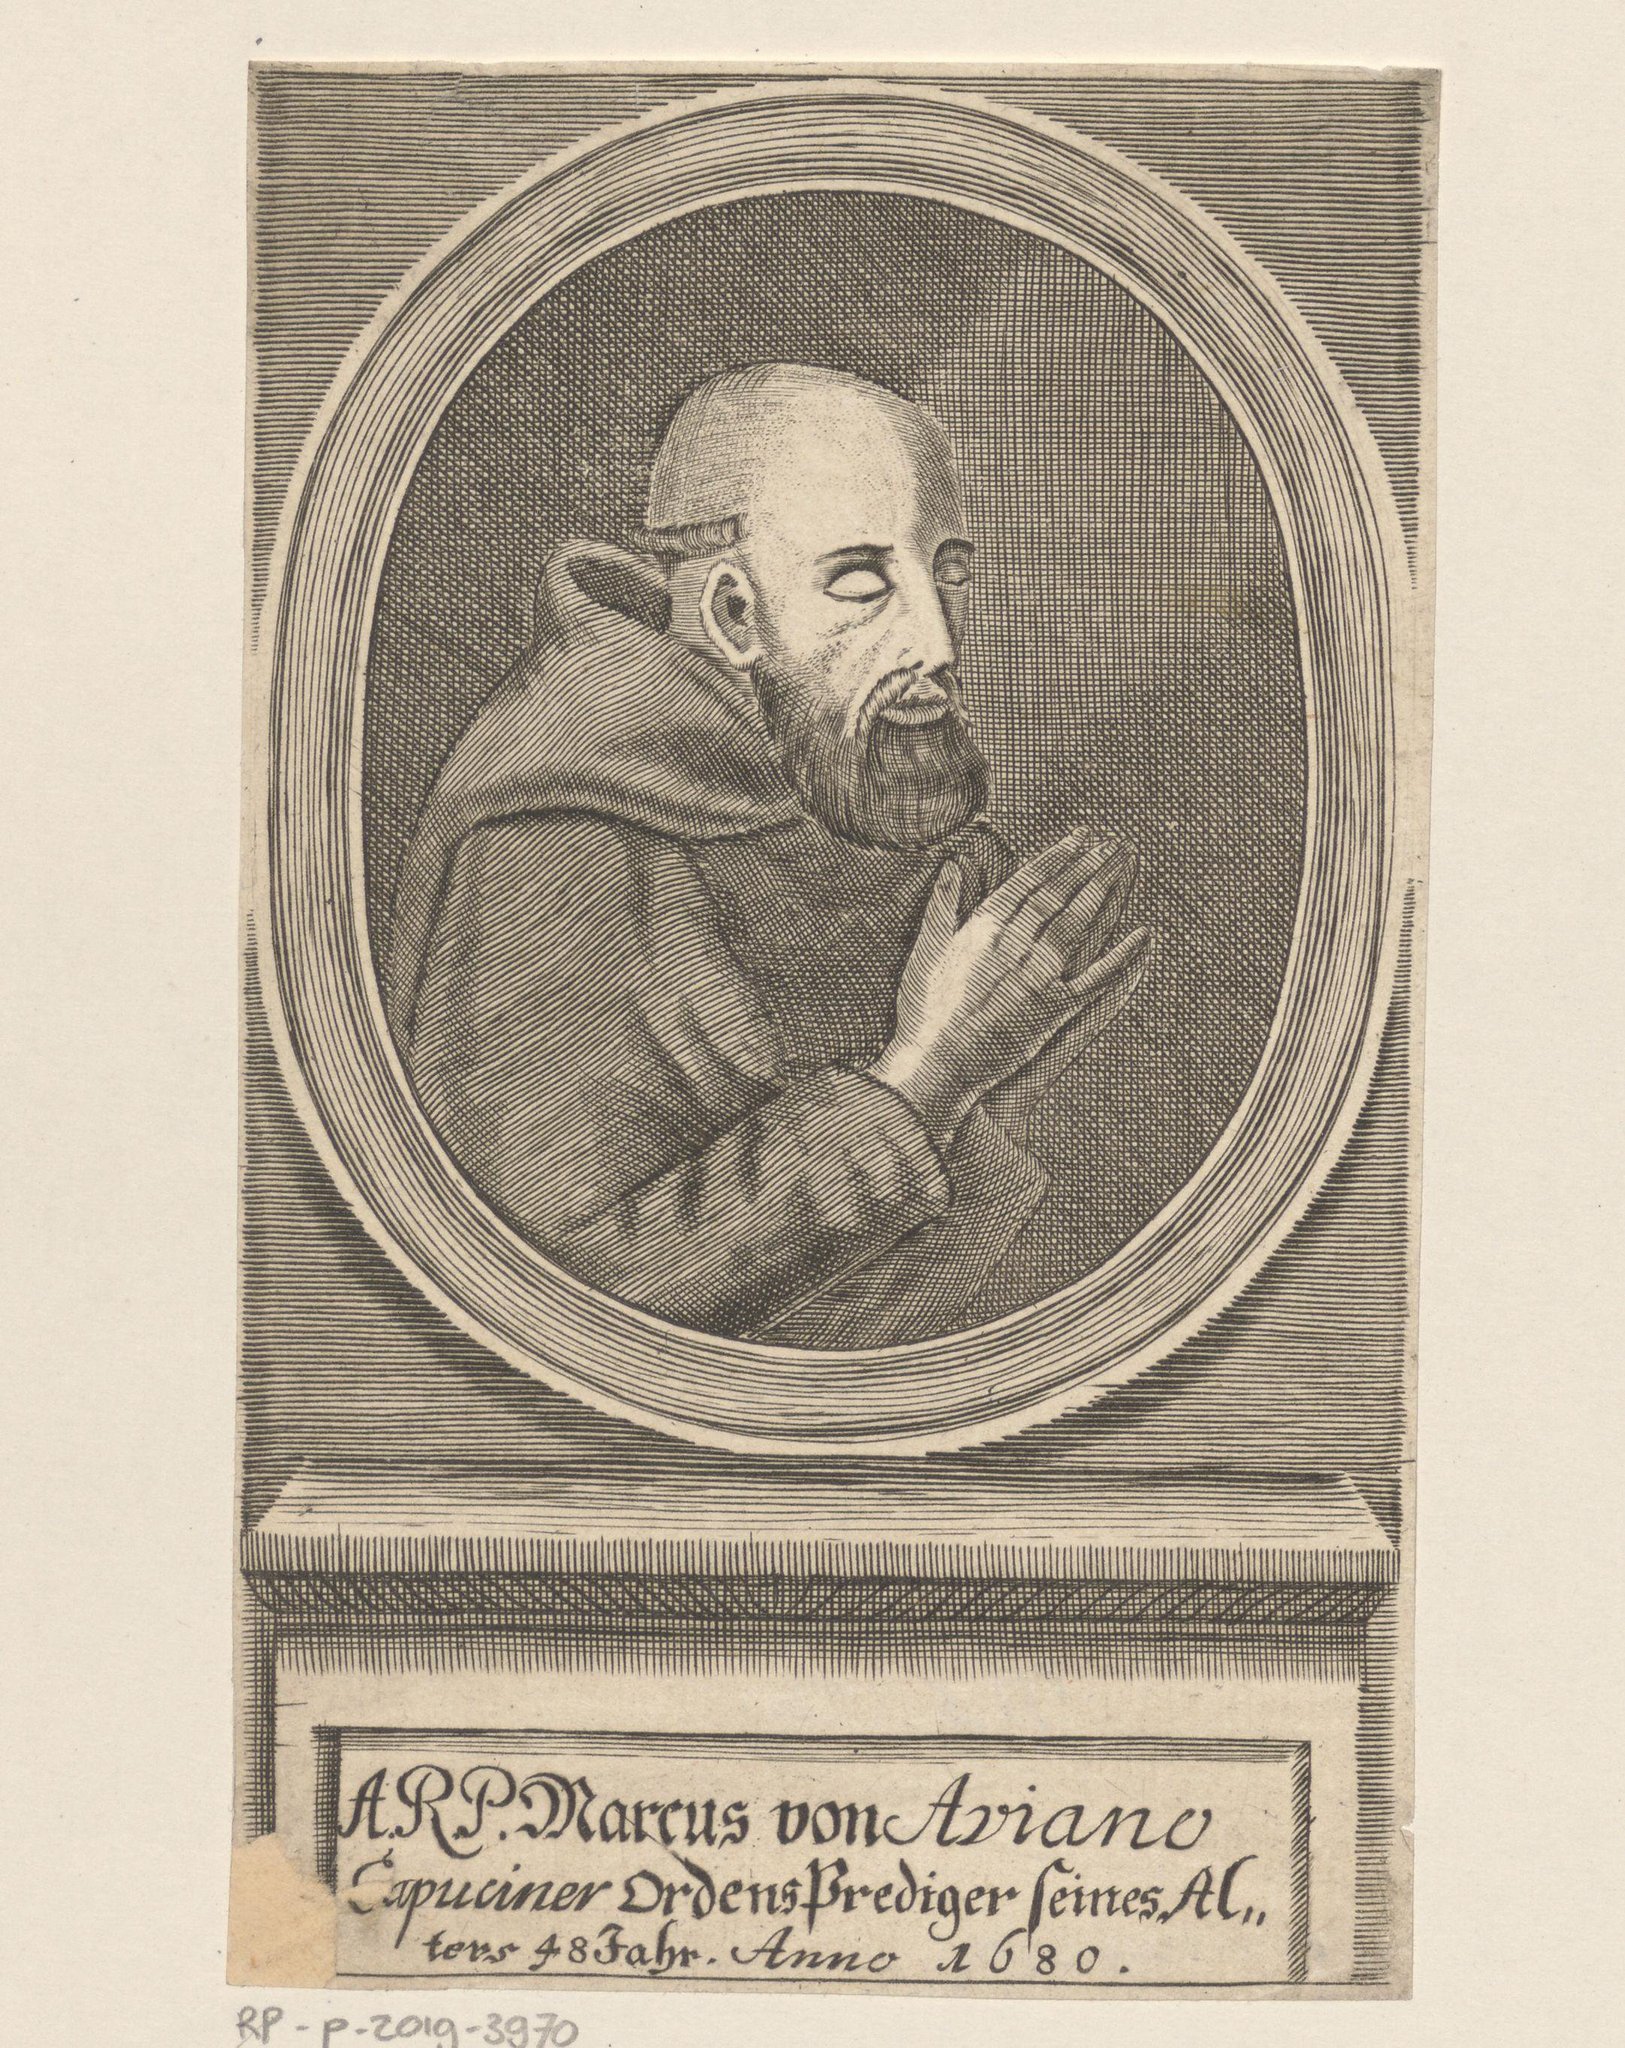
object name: book illustration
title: Portret van Marcus van Aviano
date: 1681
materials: paper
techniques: engraving, etching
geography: hamburg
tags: vienna, historical persons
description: Prent uit: Happel, Eberhard Werner. Historischer Kern, oder kurtze Chronica Der Merckwürdigsten Welt- und Wunder-Geschichte (...). Hamburg: Thomas von Wiering, 1681. Prent ook verschenen in latere edities van dit werk.